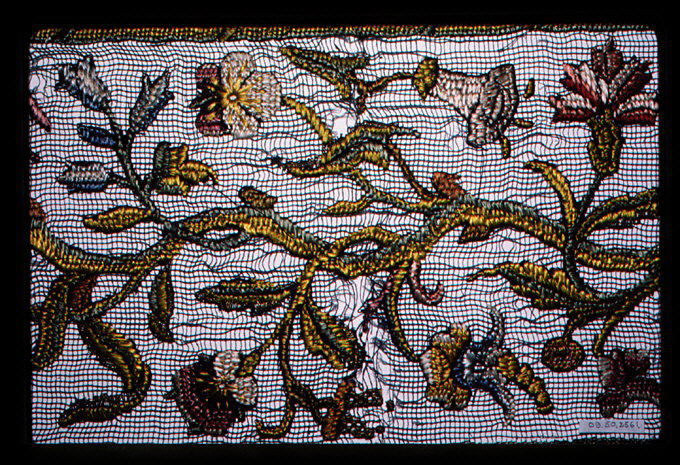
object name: fragment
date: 1601-1700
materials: silk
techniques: embroidery